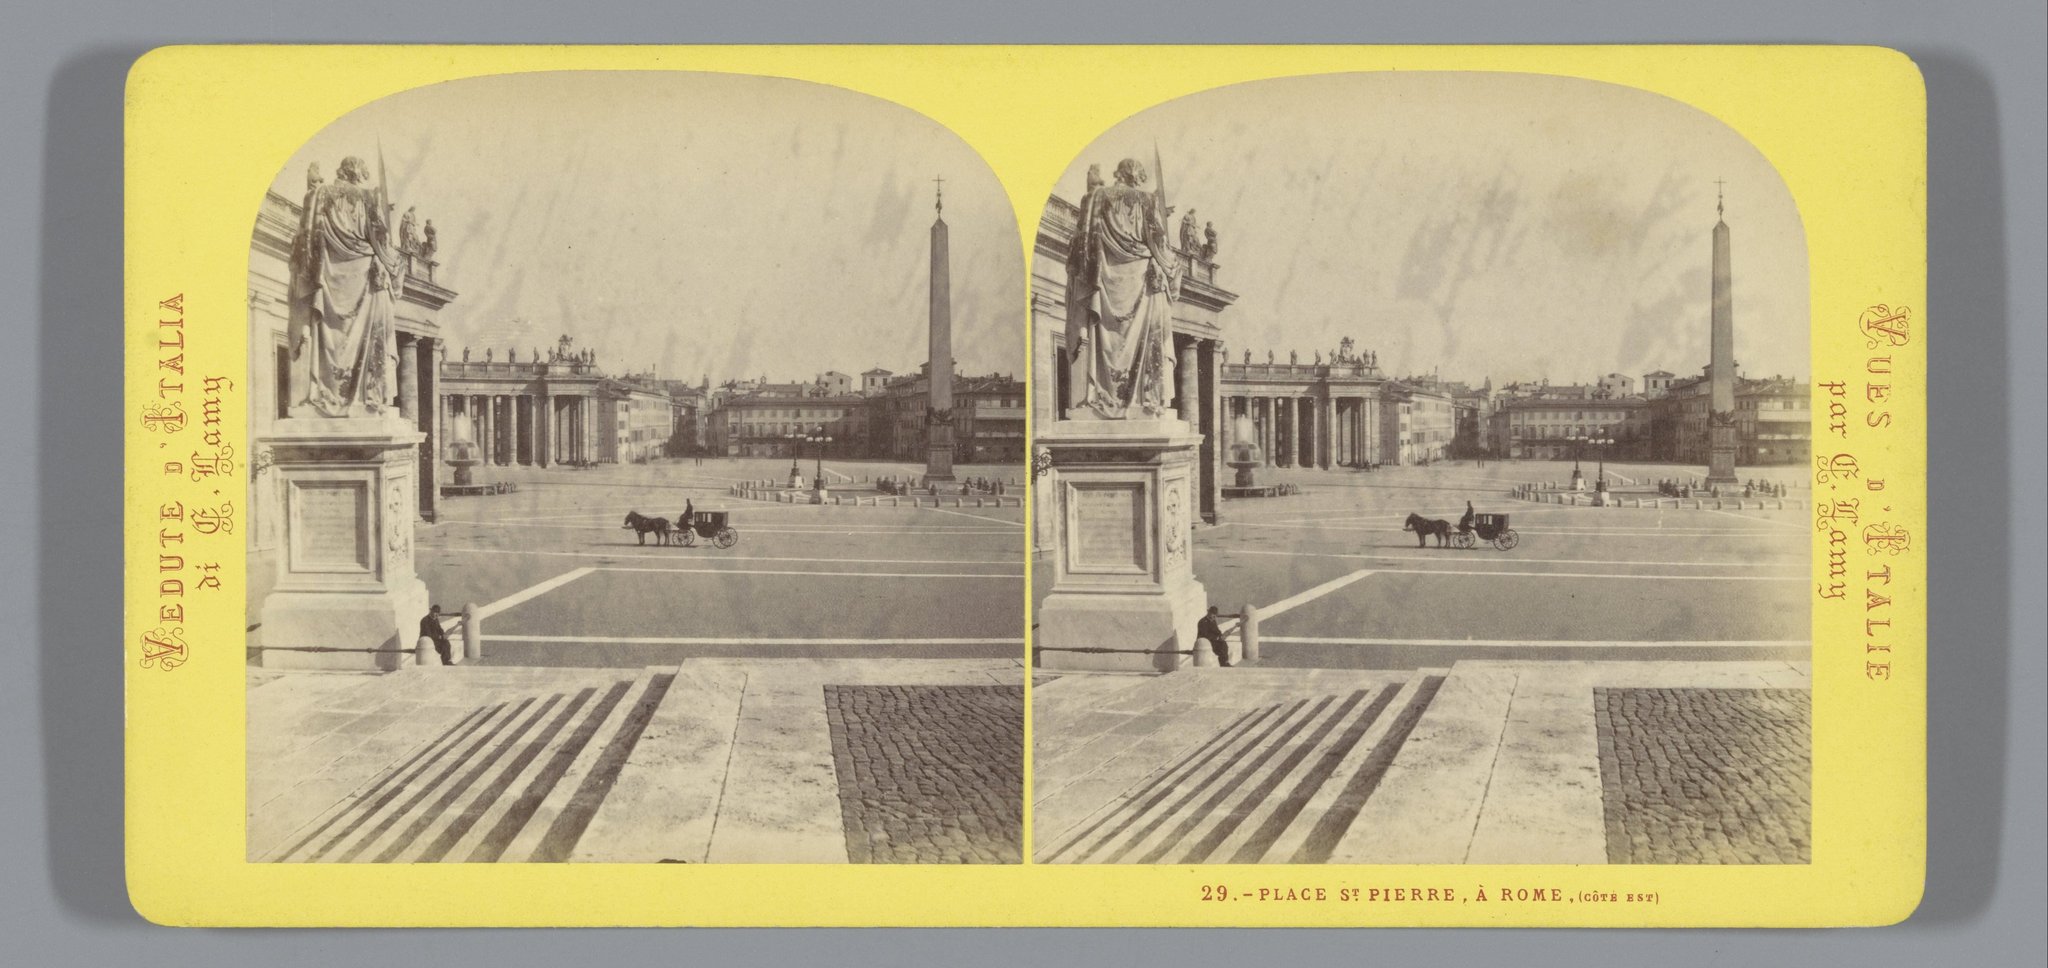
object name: stereograph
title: Sint-Pietersplein te Vaticaanstad, gezien richting het oosten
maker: ernest eléonor pierre lamy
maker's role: publisher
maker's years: 1828-1900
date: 1861-1878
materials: cardboard, paper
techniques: albumen print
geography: vatican city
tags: square, place, circus, etc., obelisk, needle, monument, statue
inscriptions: number: ‘29.’